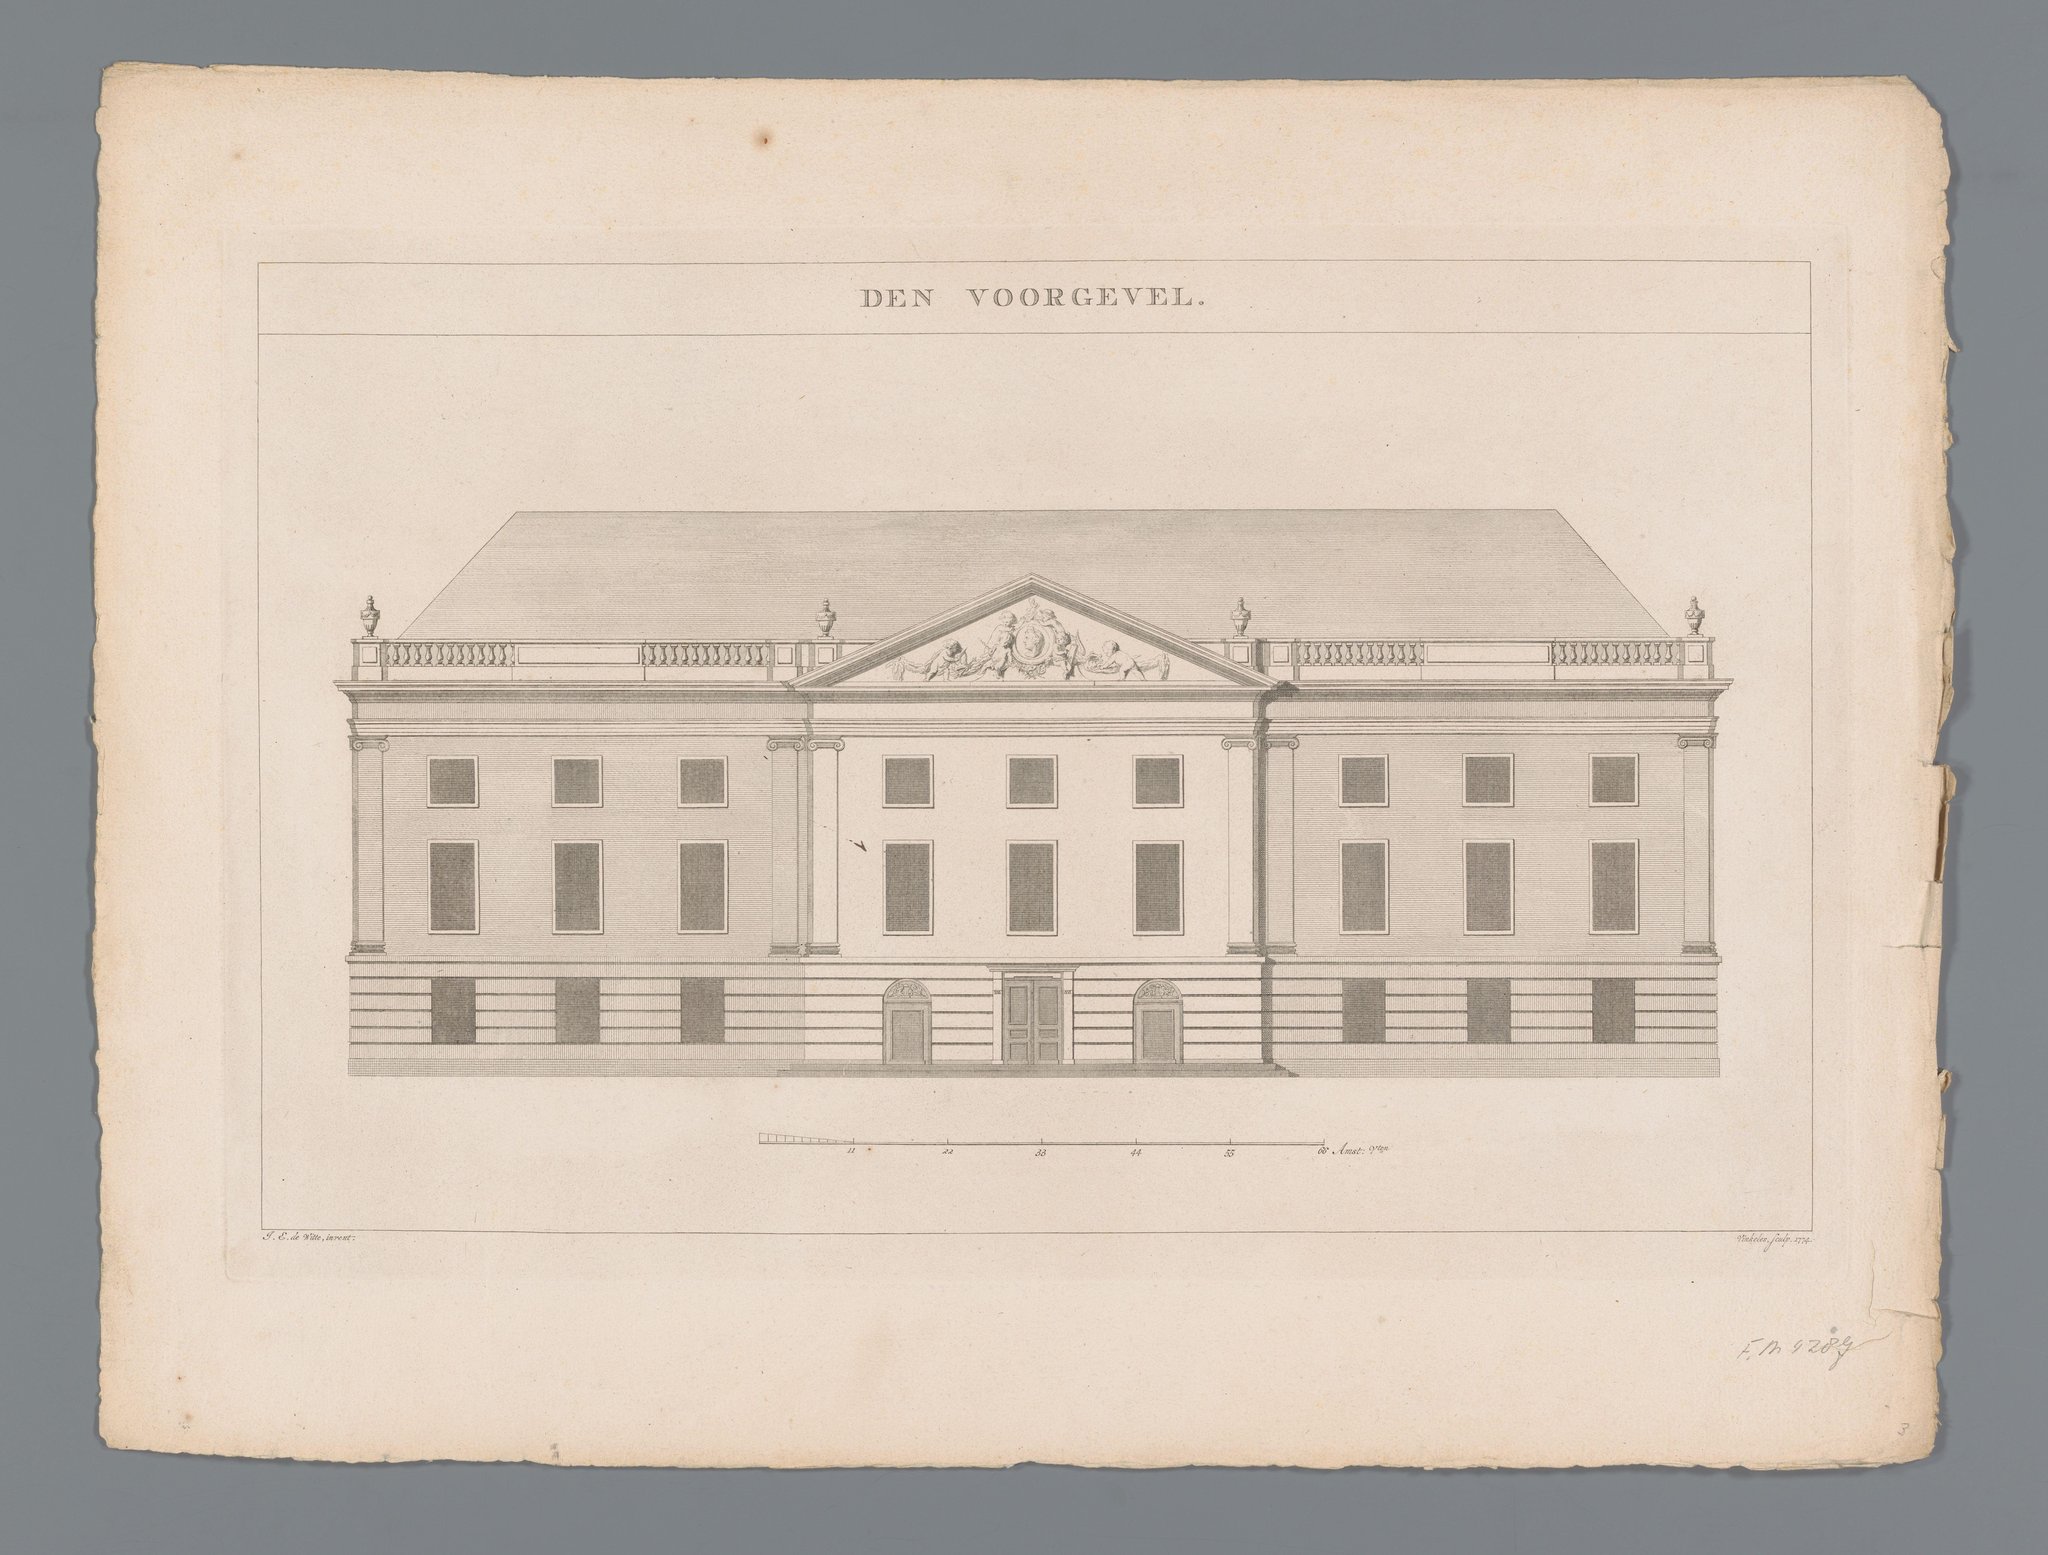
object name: print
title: Voorgevel van de schouwburg aan het Leidseplein te Amsterdam, 1774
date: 1774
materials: paper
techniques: etching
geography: amsterdam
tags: theatre (building), amsterdam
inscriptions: date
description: Prent uit: Witte, Jacob Eduard de. Afbeeldingen van den schouwburg te Amsterdam. Amsterdam: Johannes Smit, 1774.